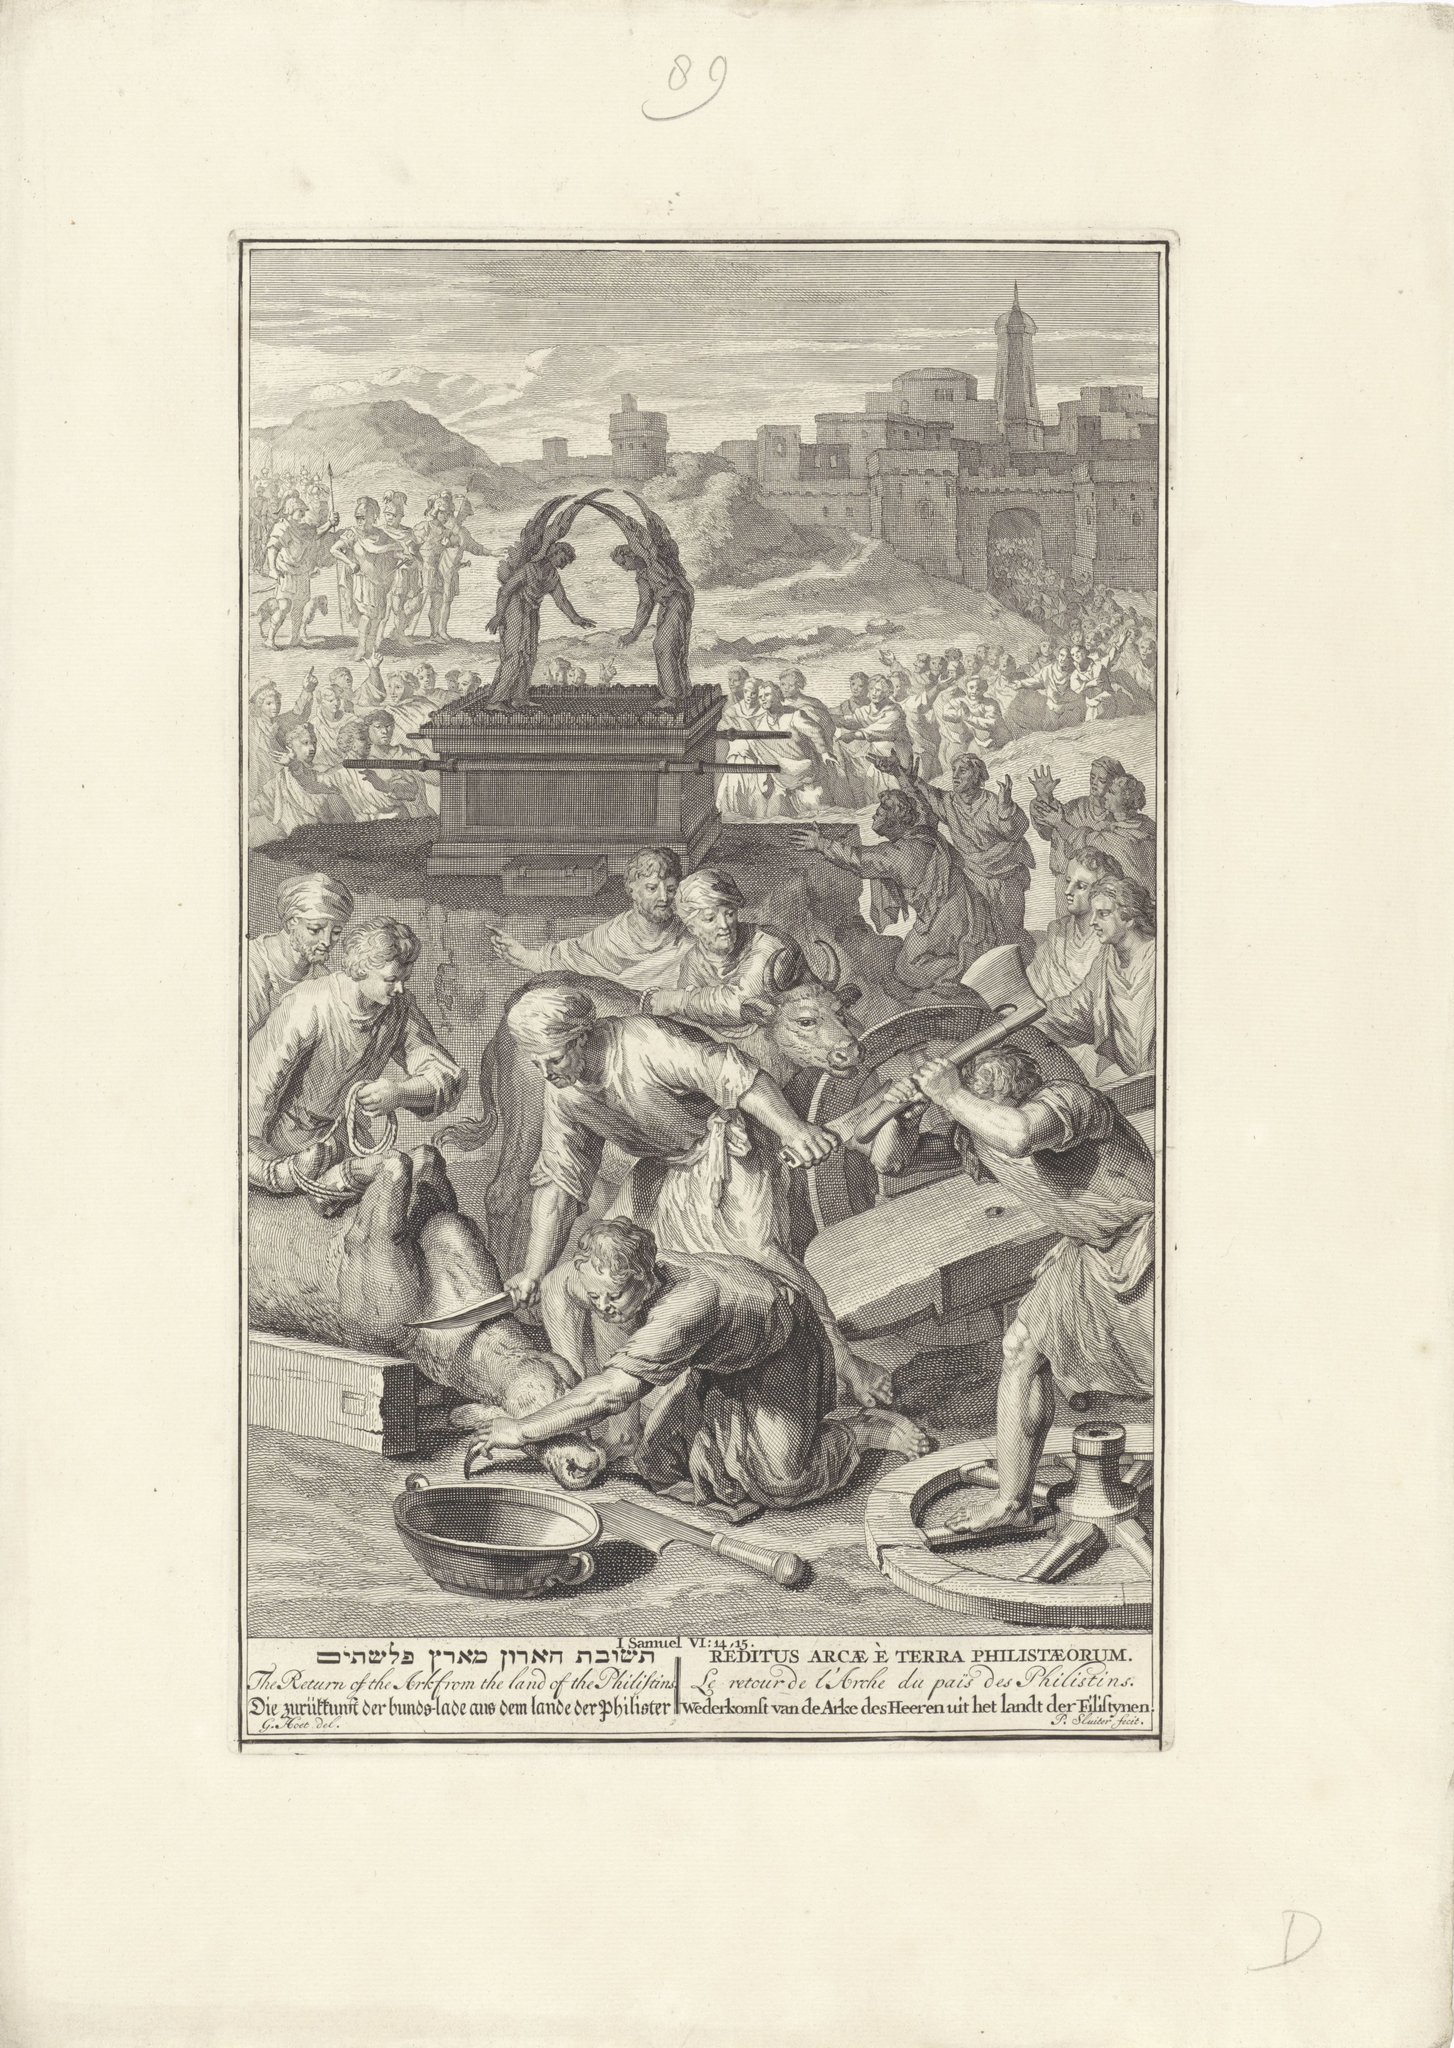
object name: print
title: Terugkomst van de ark des verbonds uit het land der Filistijnen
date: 1705-1720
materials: paper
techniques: engraving, etching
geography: amsterdam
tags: the ark of the covenant and the box with the guilt offering, drawn by two cows, sent back to israel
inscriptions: collector's mark: Lugt 2228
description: Het volk stroomt uit de stad ter verwelkoming van de ark des verbonds, die op een verhoging buiten de stad staat. Mannen staan op het punt een kalf te offeren. Een tweede kalf wordt naar de offerplaats geleid. Illustratie van de Bijbeltekst 1 Sam. 6: 14-15. Onder de voorstelling de titel in het Hebreeuws, Engels, Duits, Latijn, Frans en Nederlands.